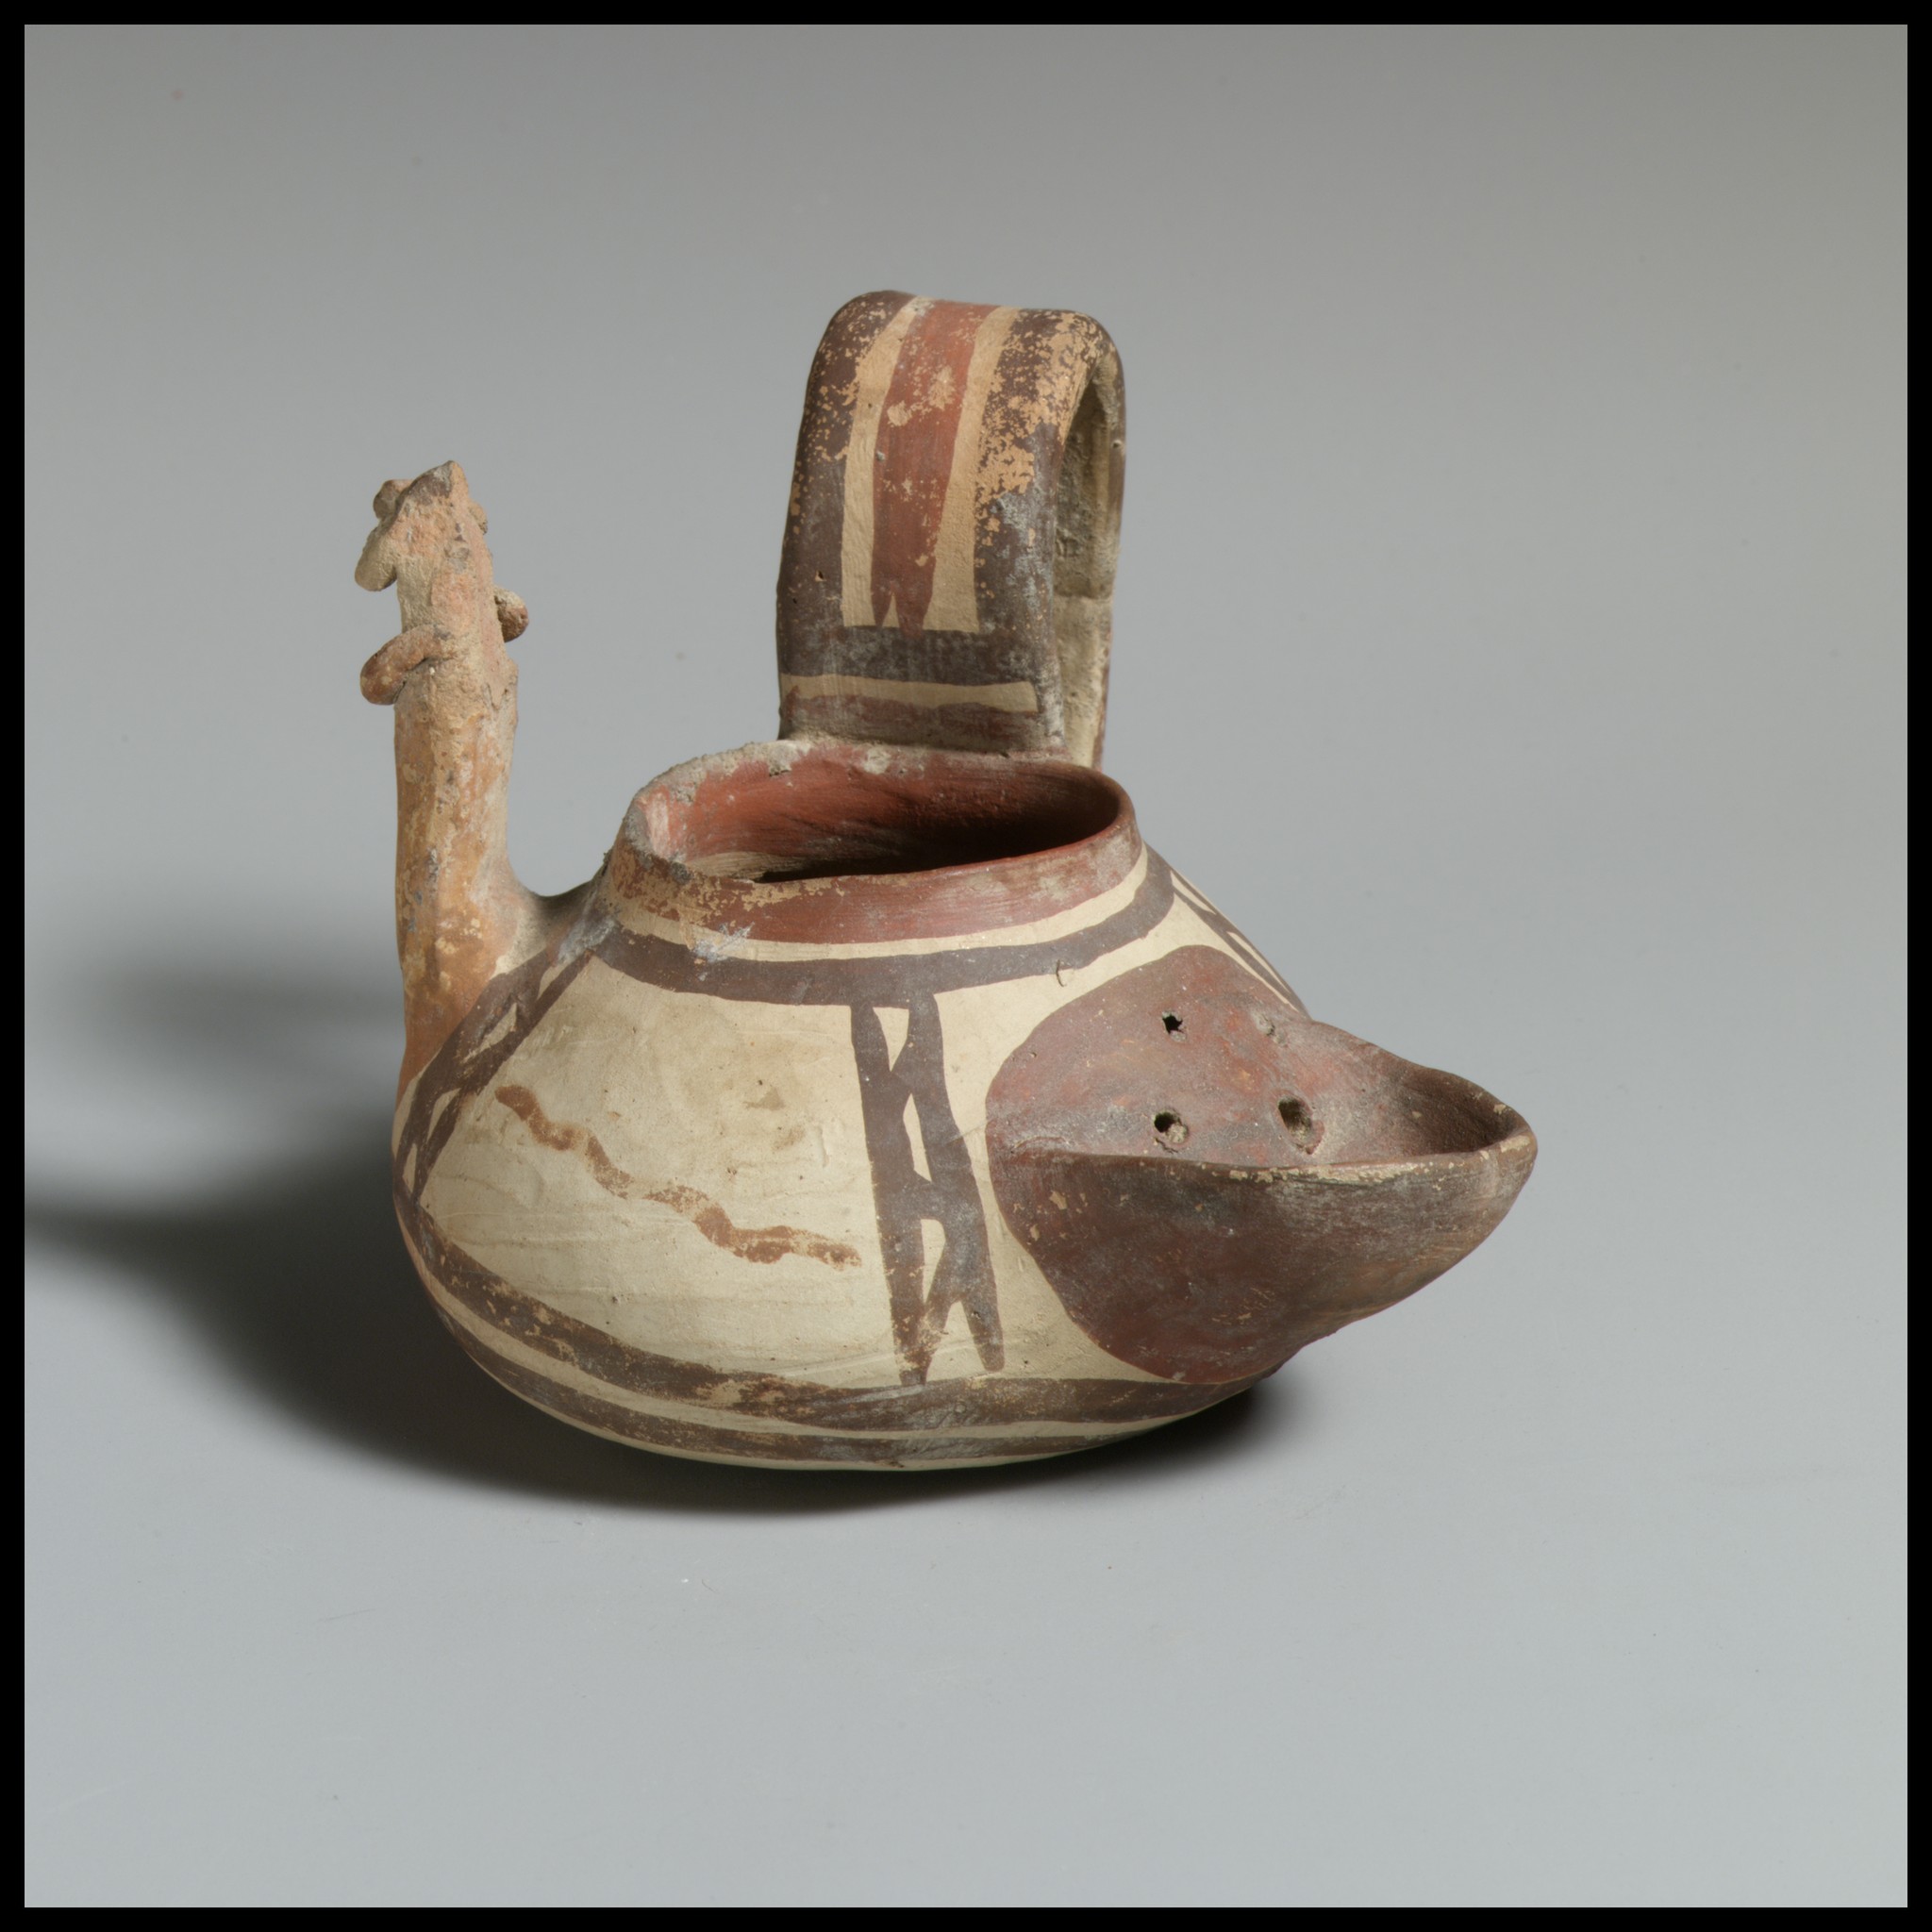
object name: strainer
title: Terracotta one-handled vase with strainer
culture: italic, daunian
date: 467-435 BCE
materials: terracotta